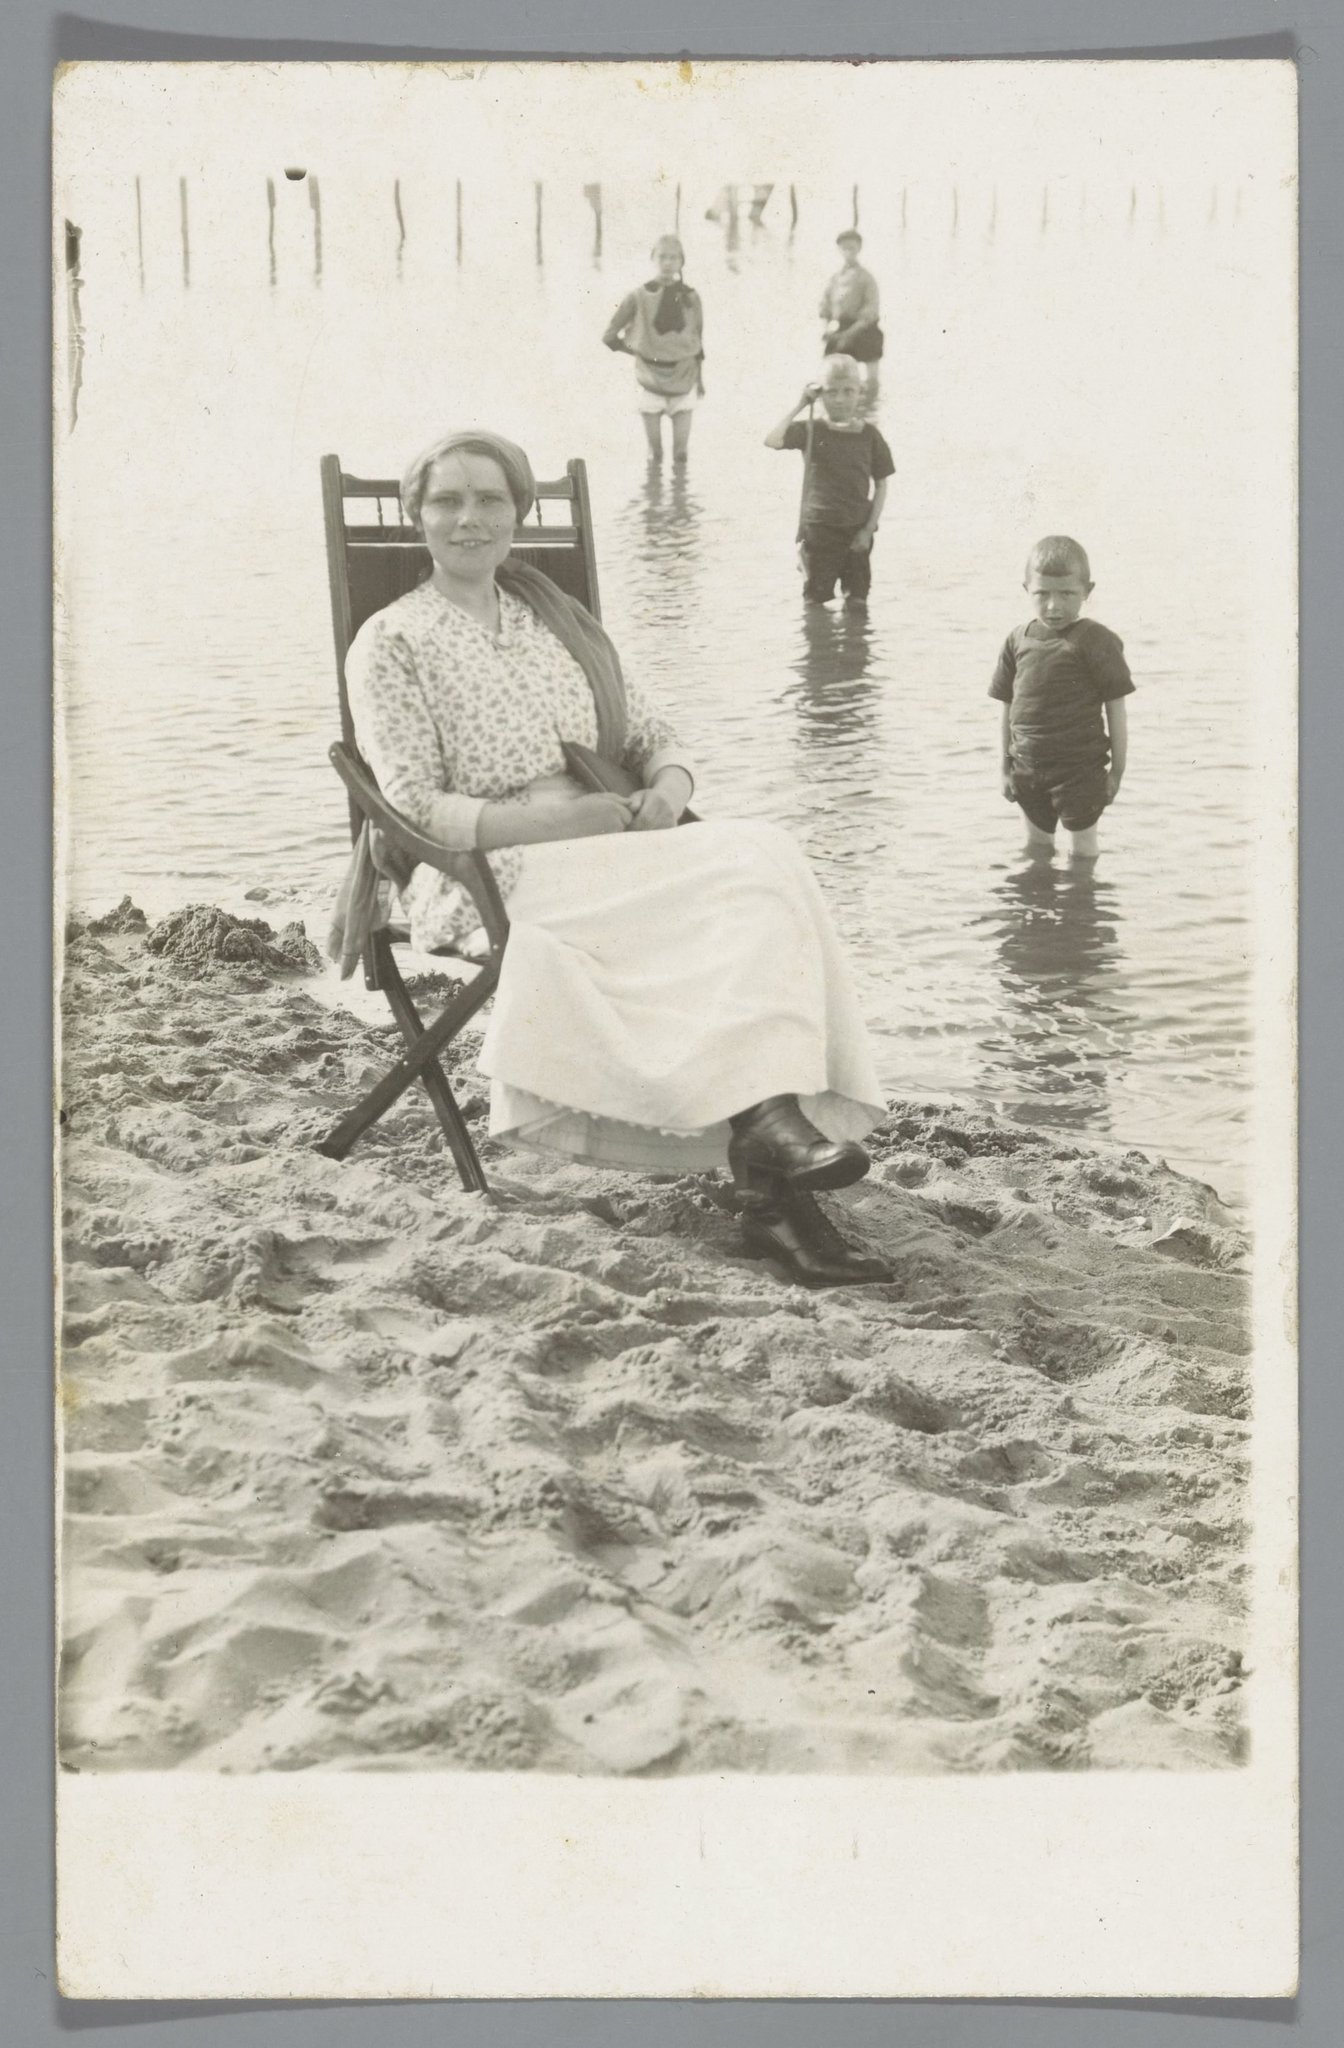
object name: ansichtkaart, prentbriefkaart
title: Portret van een onbekende vrouw in een vouwstoel op het strand, met vier kinderen op de achtergrond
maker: Anonymous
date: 1910-1935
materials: photographic support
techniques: gelatin silver print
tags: beach (as place of recreation), mother and child(ren), woman and child(ren) (family group)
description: Een deel van hetzelfde gezelschap is afgebeeld op RP-F-F21465 en RP-F-F21464.